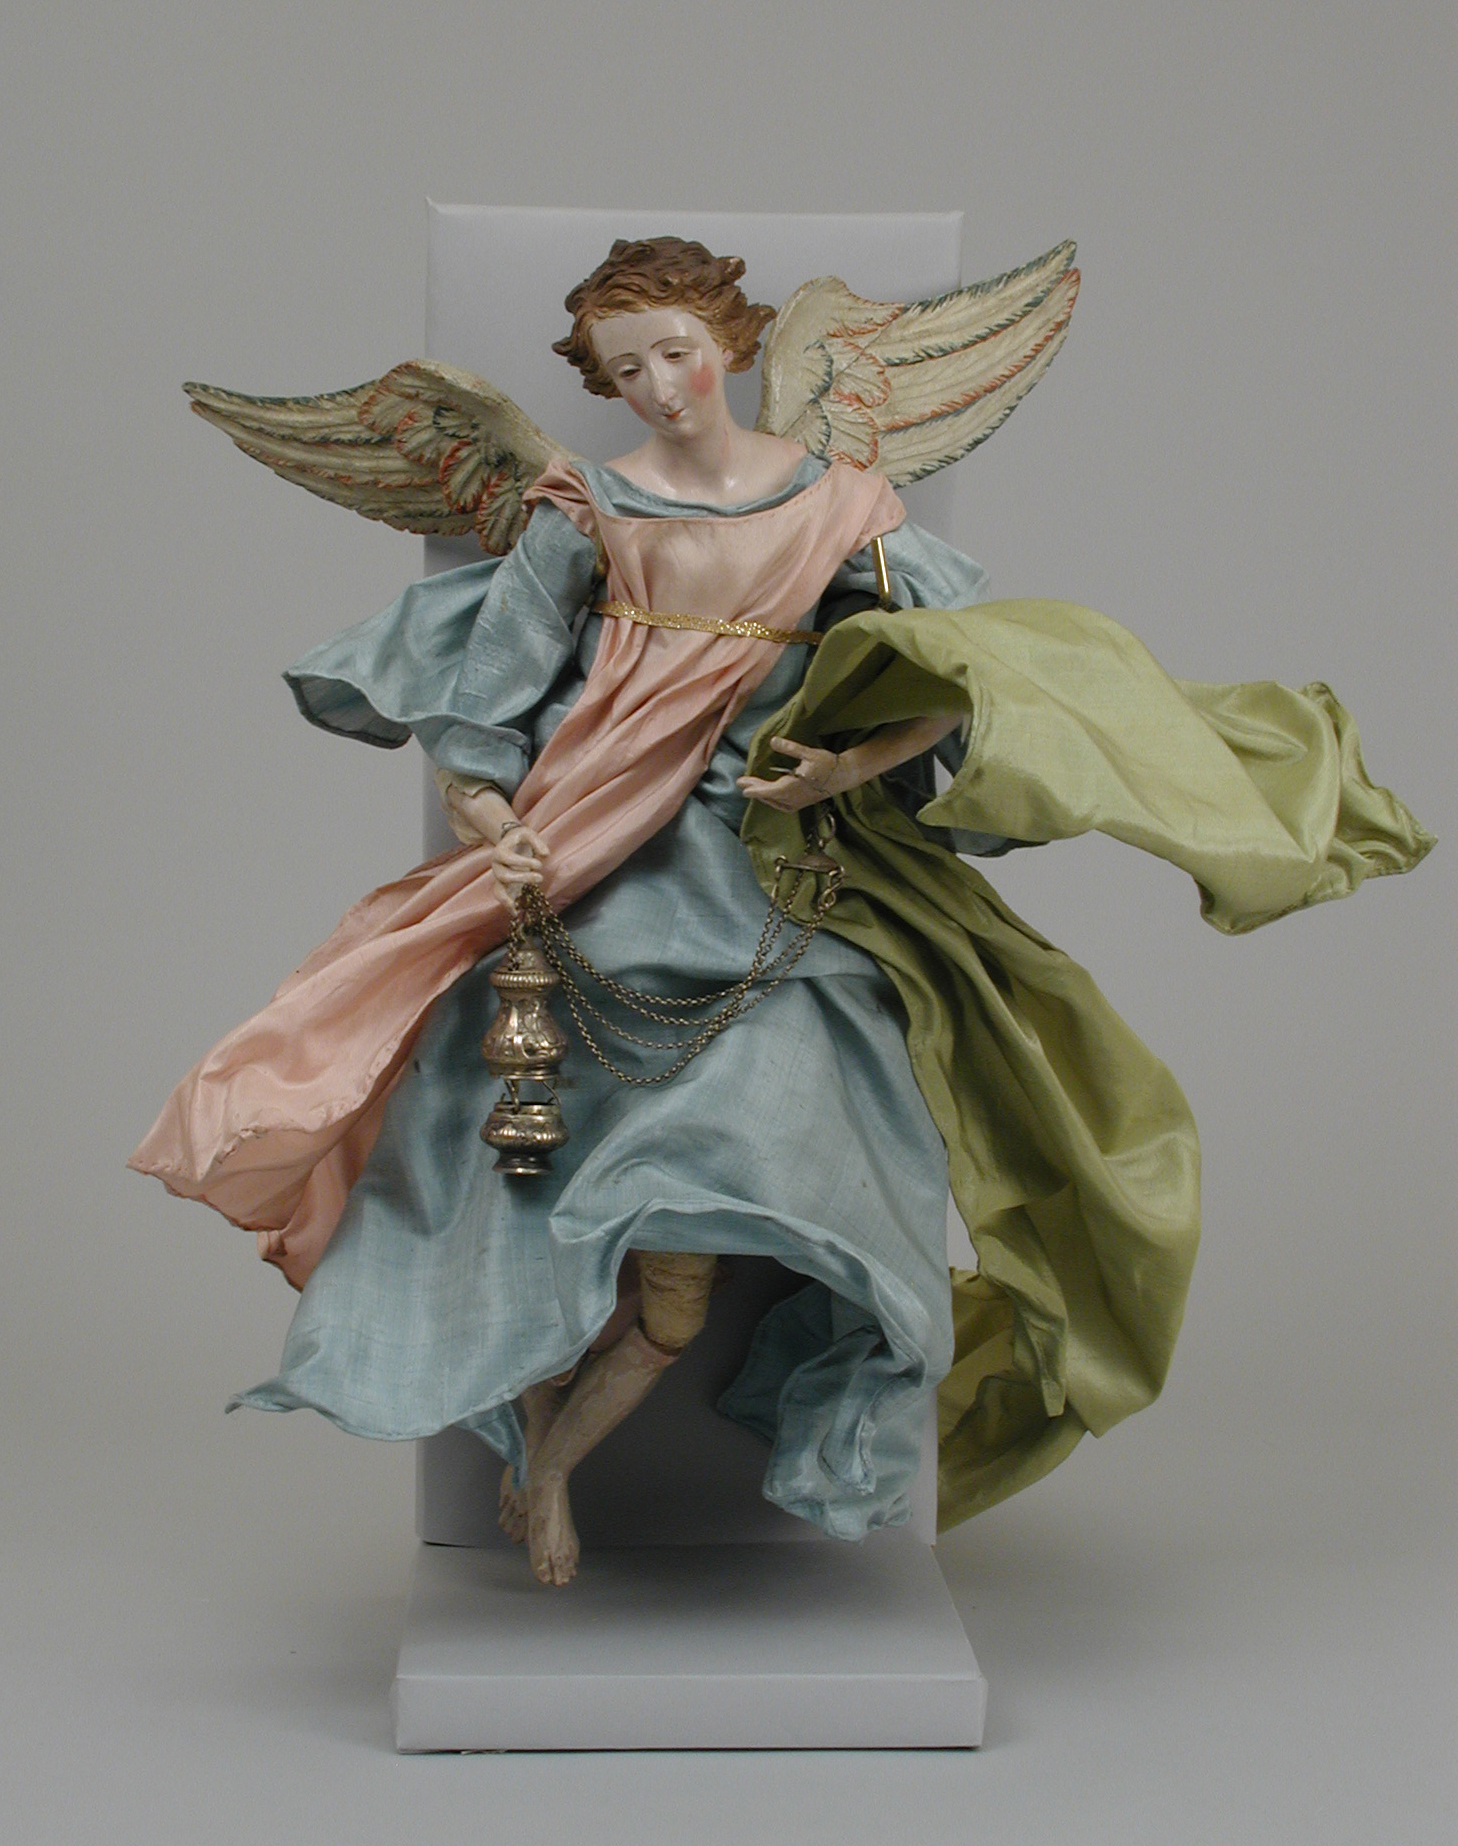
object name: crèche figure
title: Angel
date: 1751-1800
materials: terracotta, fiber, metal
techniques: polychrome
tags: angels